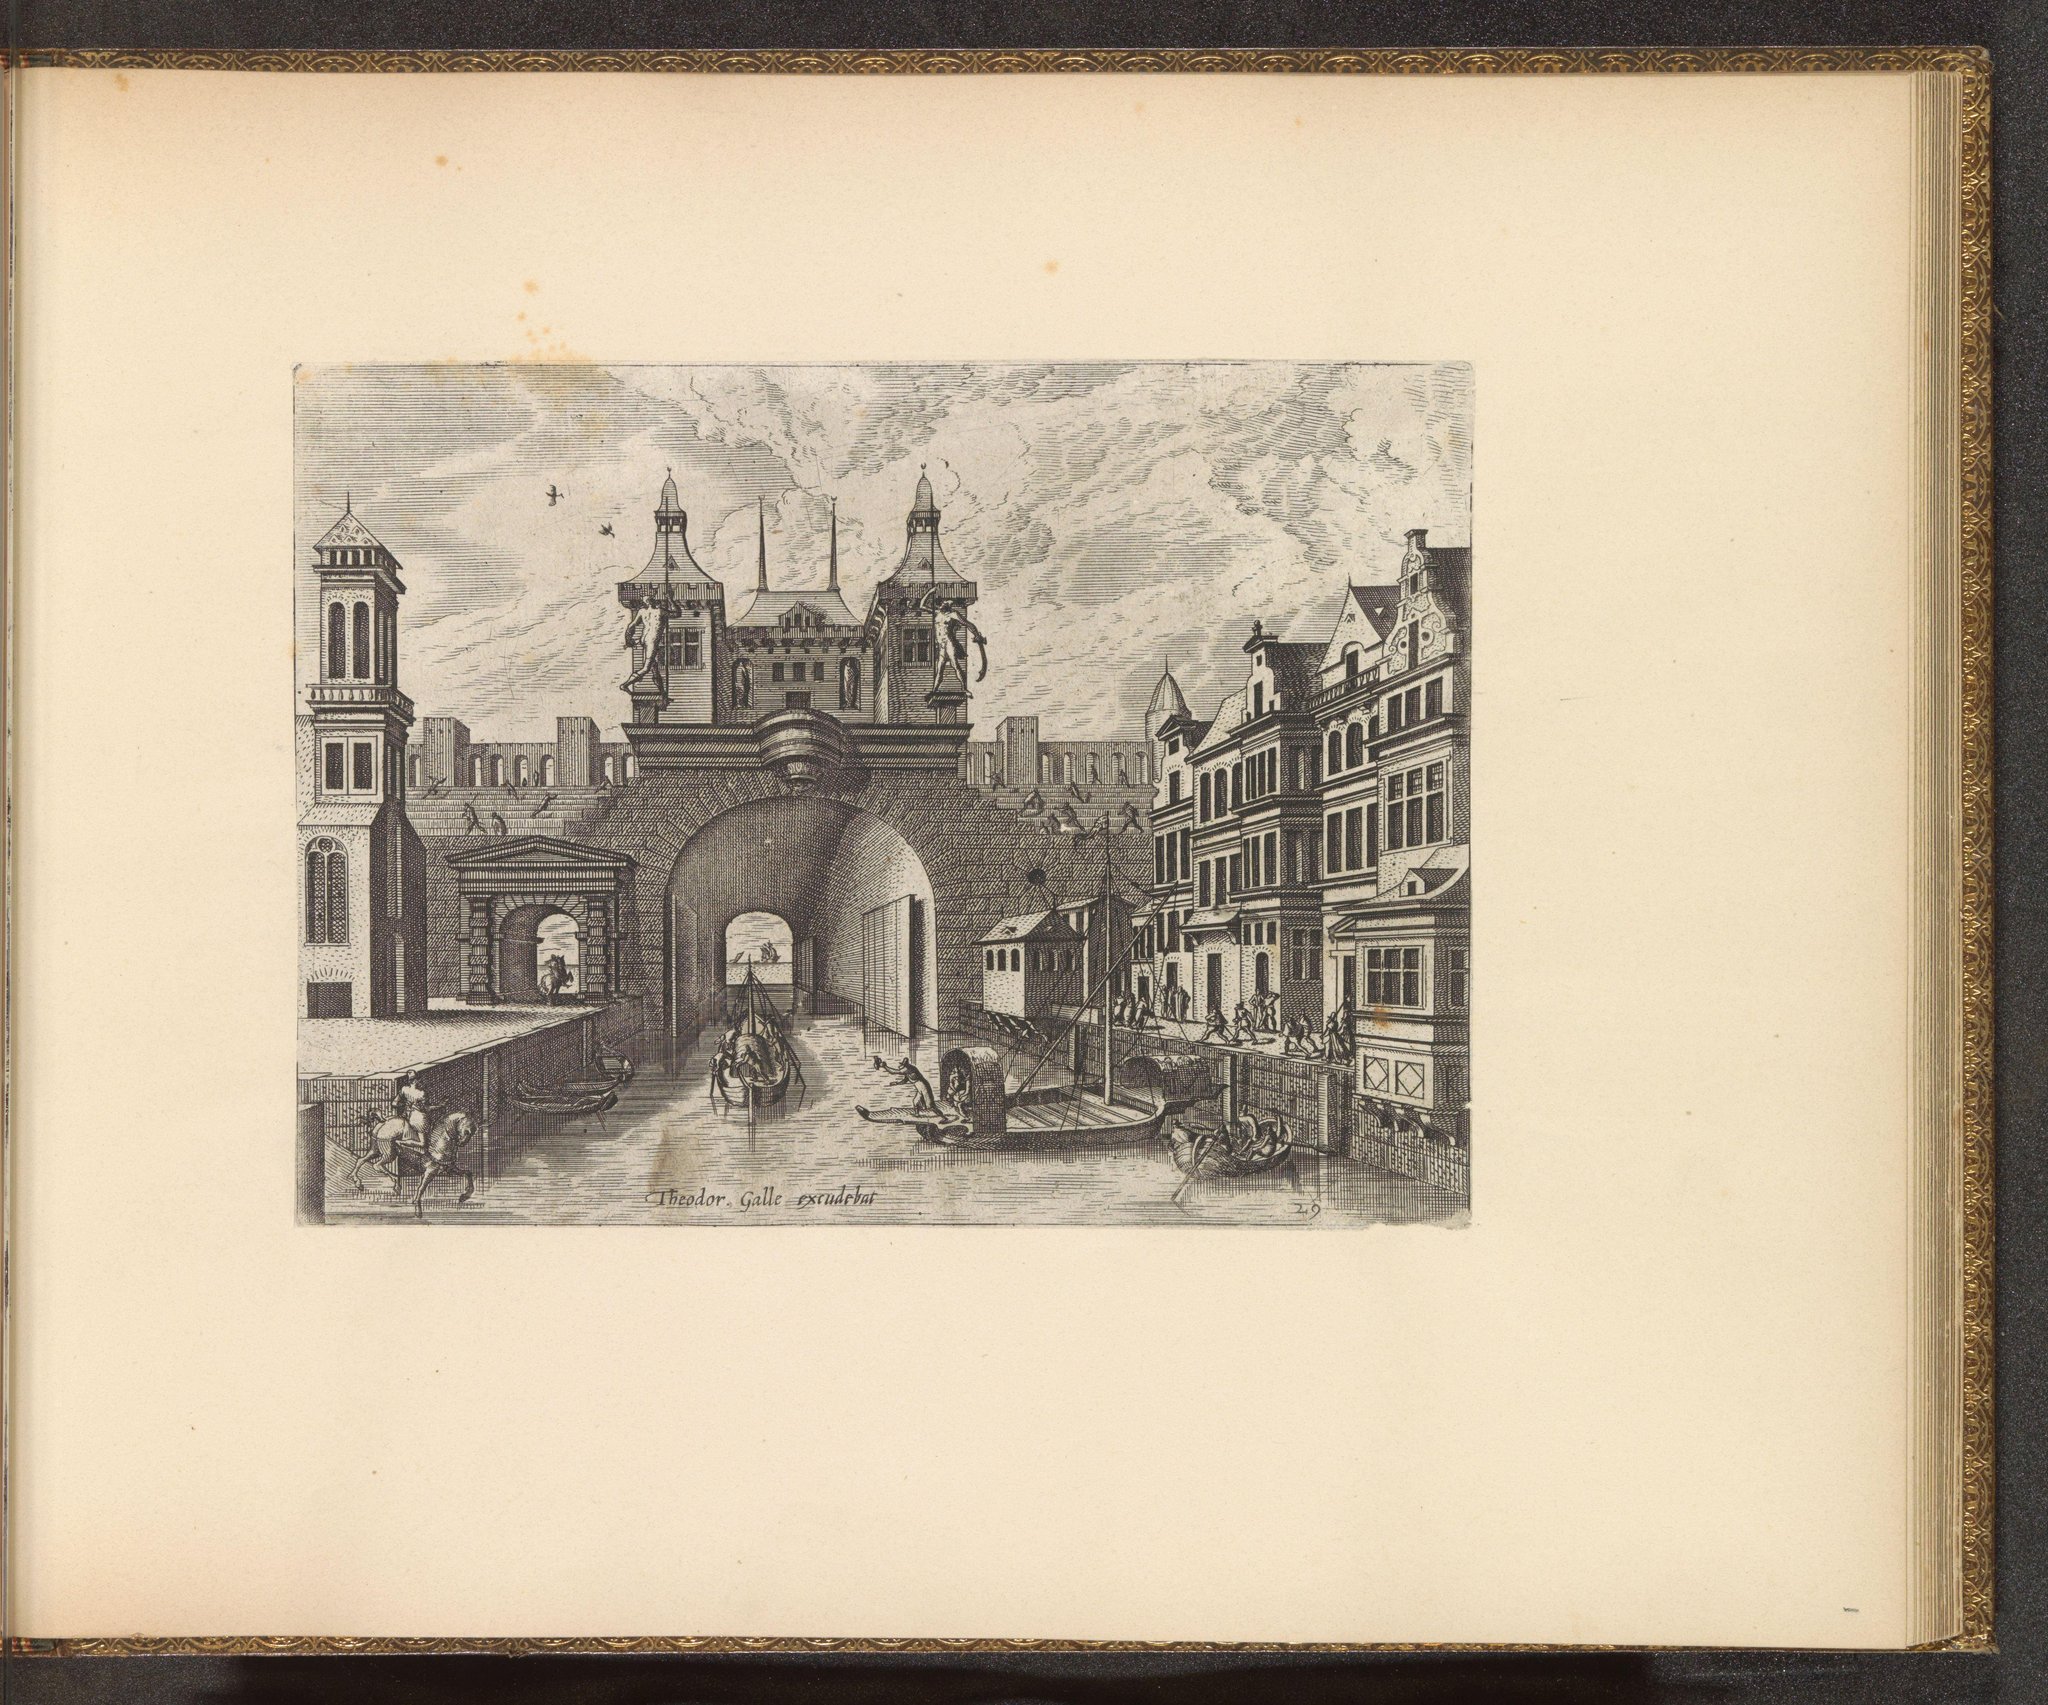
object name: album leaf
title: Architectuurperspectieven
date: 1601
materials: paper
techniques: etching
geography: antwerp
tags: watergate, city-view in general; 'veduta'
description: Waterpoort met opbouw, vanuit de stad gezien. Links ligt een kleine landpoort, rechts een kade met woonhuizen. In de gracht liggen boten. De prent maakt deel uit van een album.